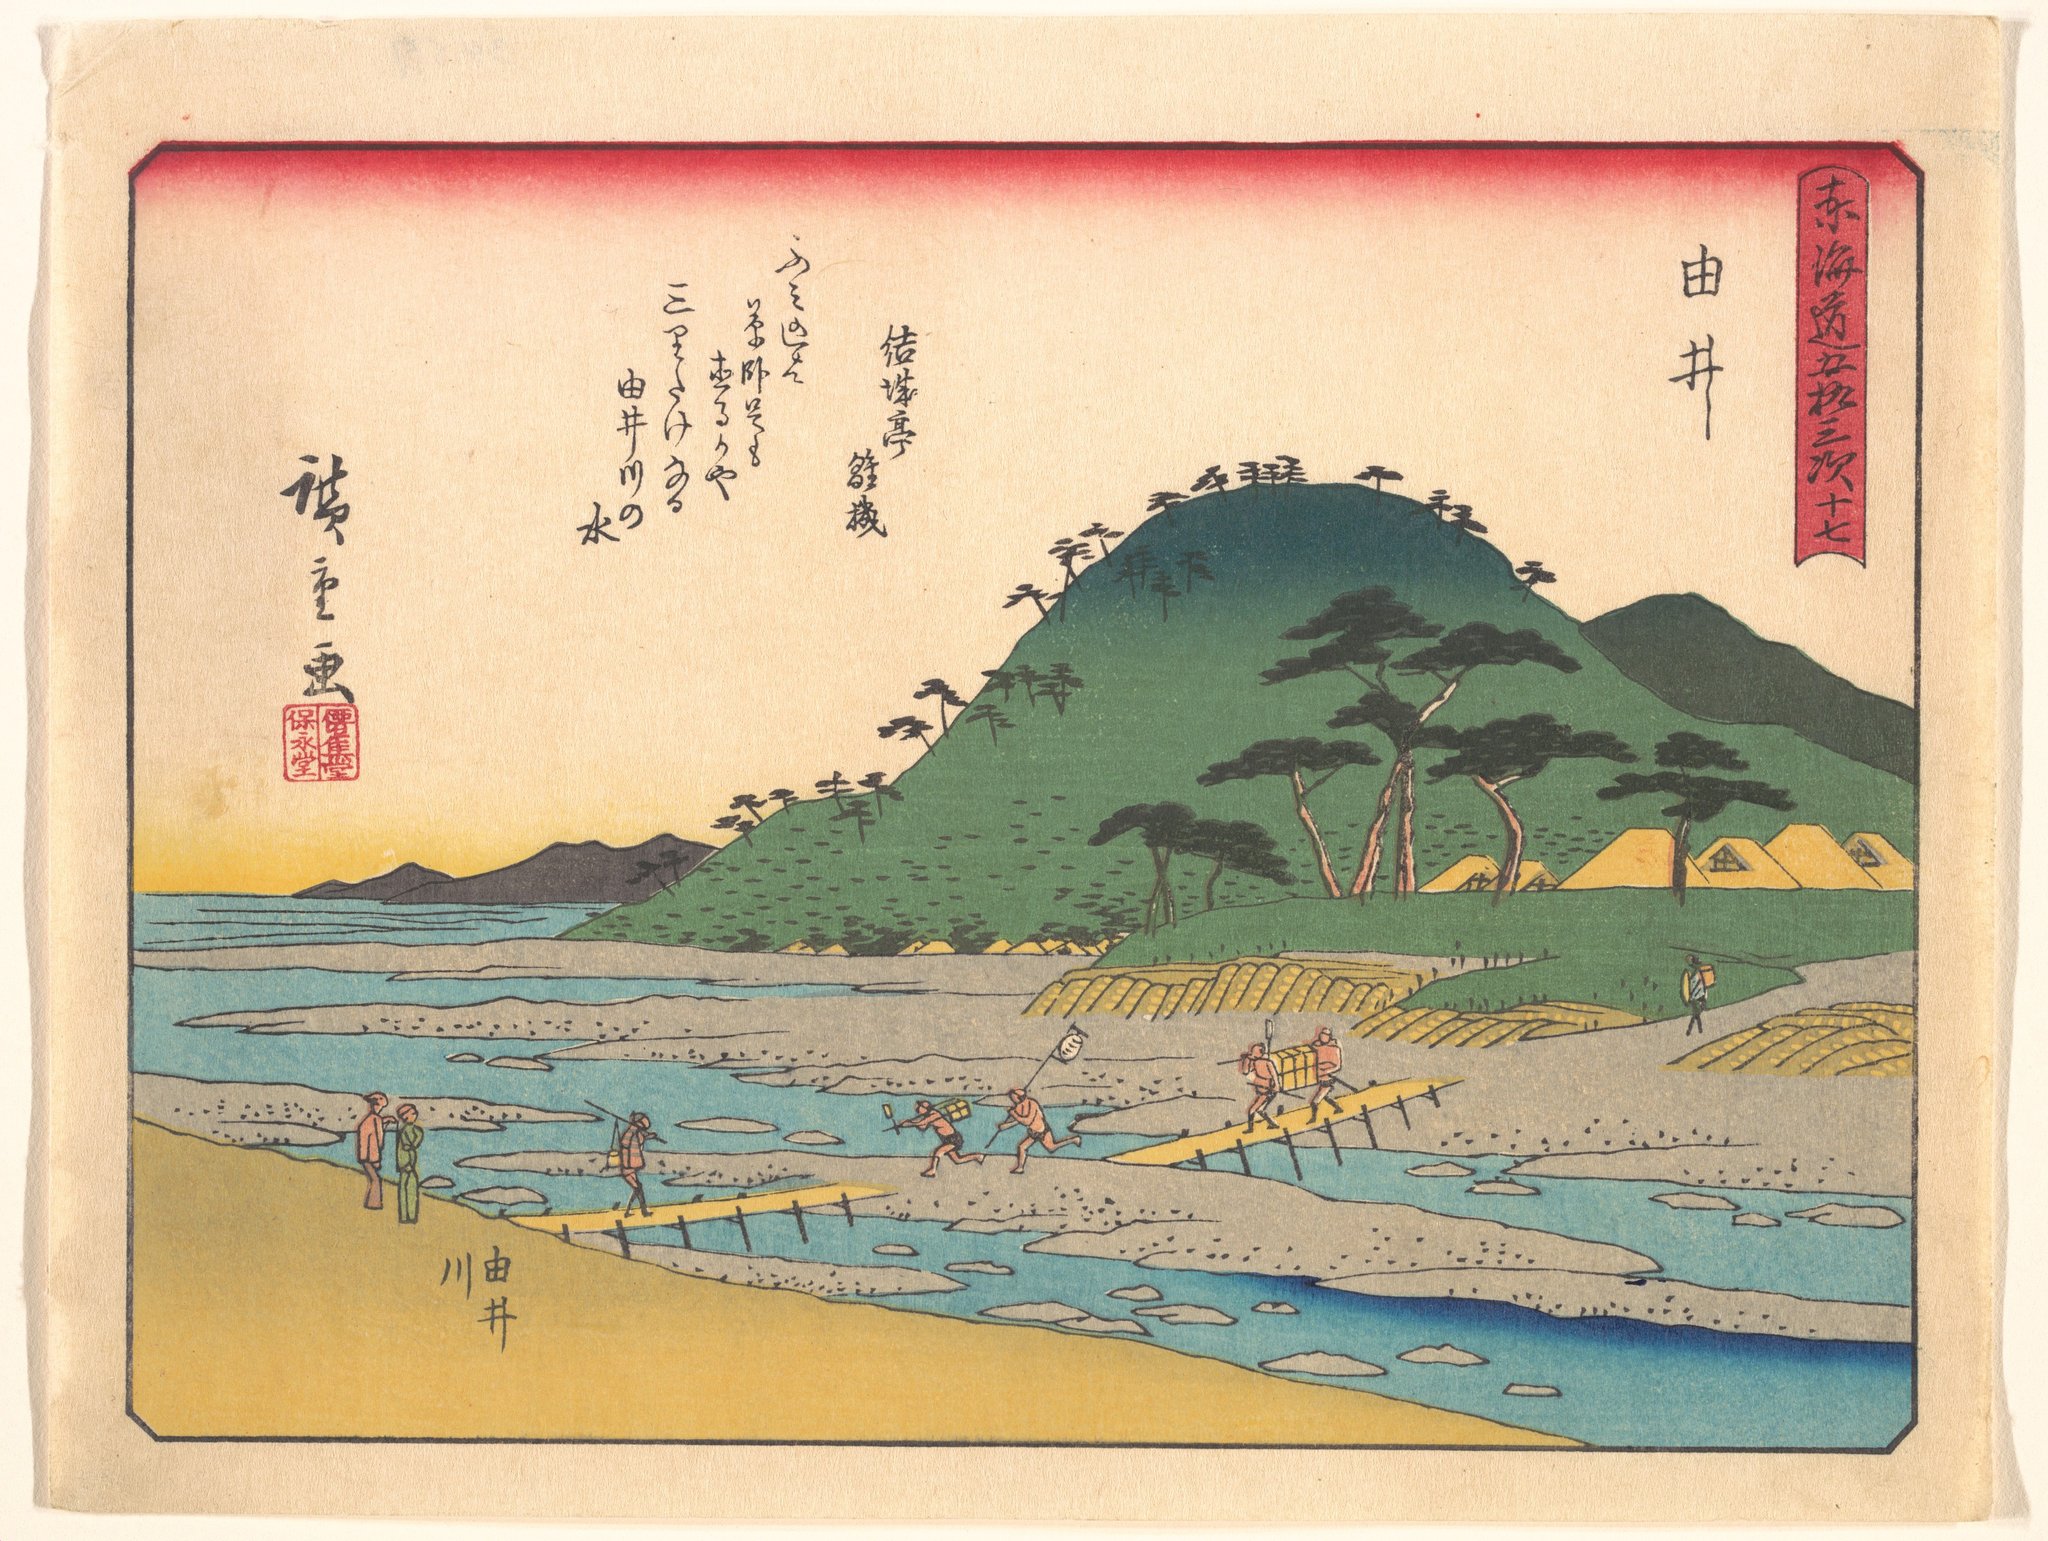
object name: print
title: 東海道五十三次 由井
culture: japanese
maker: utagawa hiroshige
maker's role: artist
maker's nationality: japanese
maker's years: 1797-1858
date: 1901-1933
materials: ink, paper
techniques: woodblock print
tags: bridges,hills,landscapes,streams